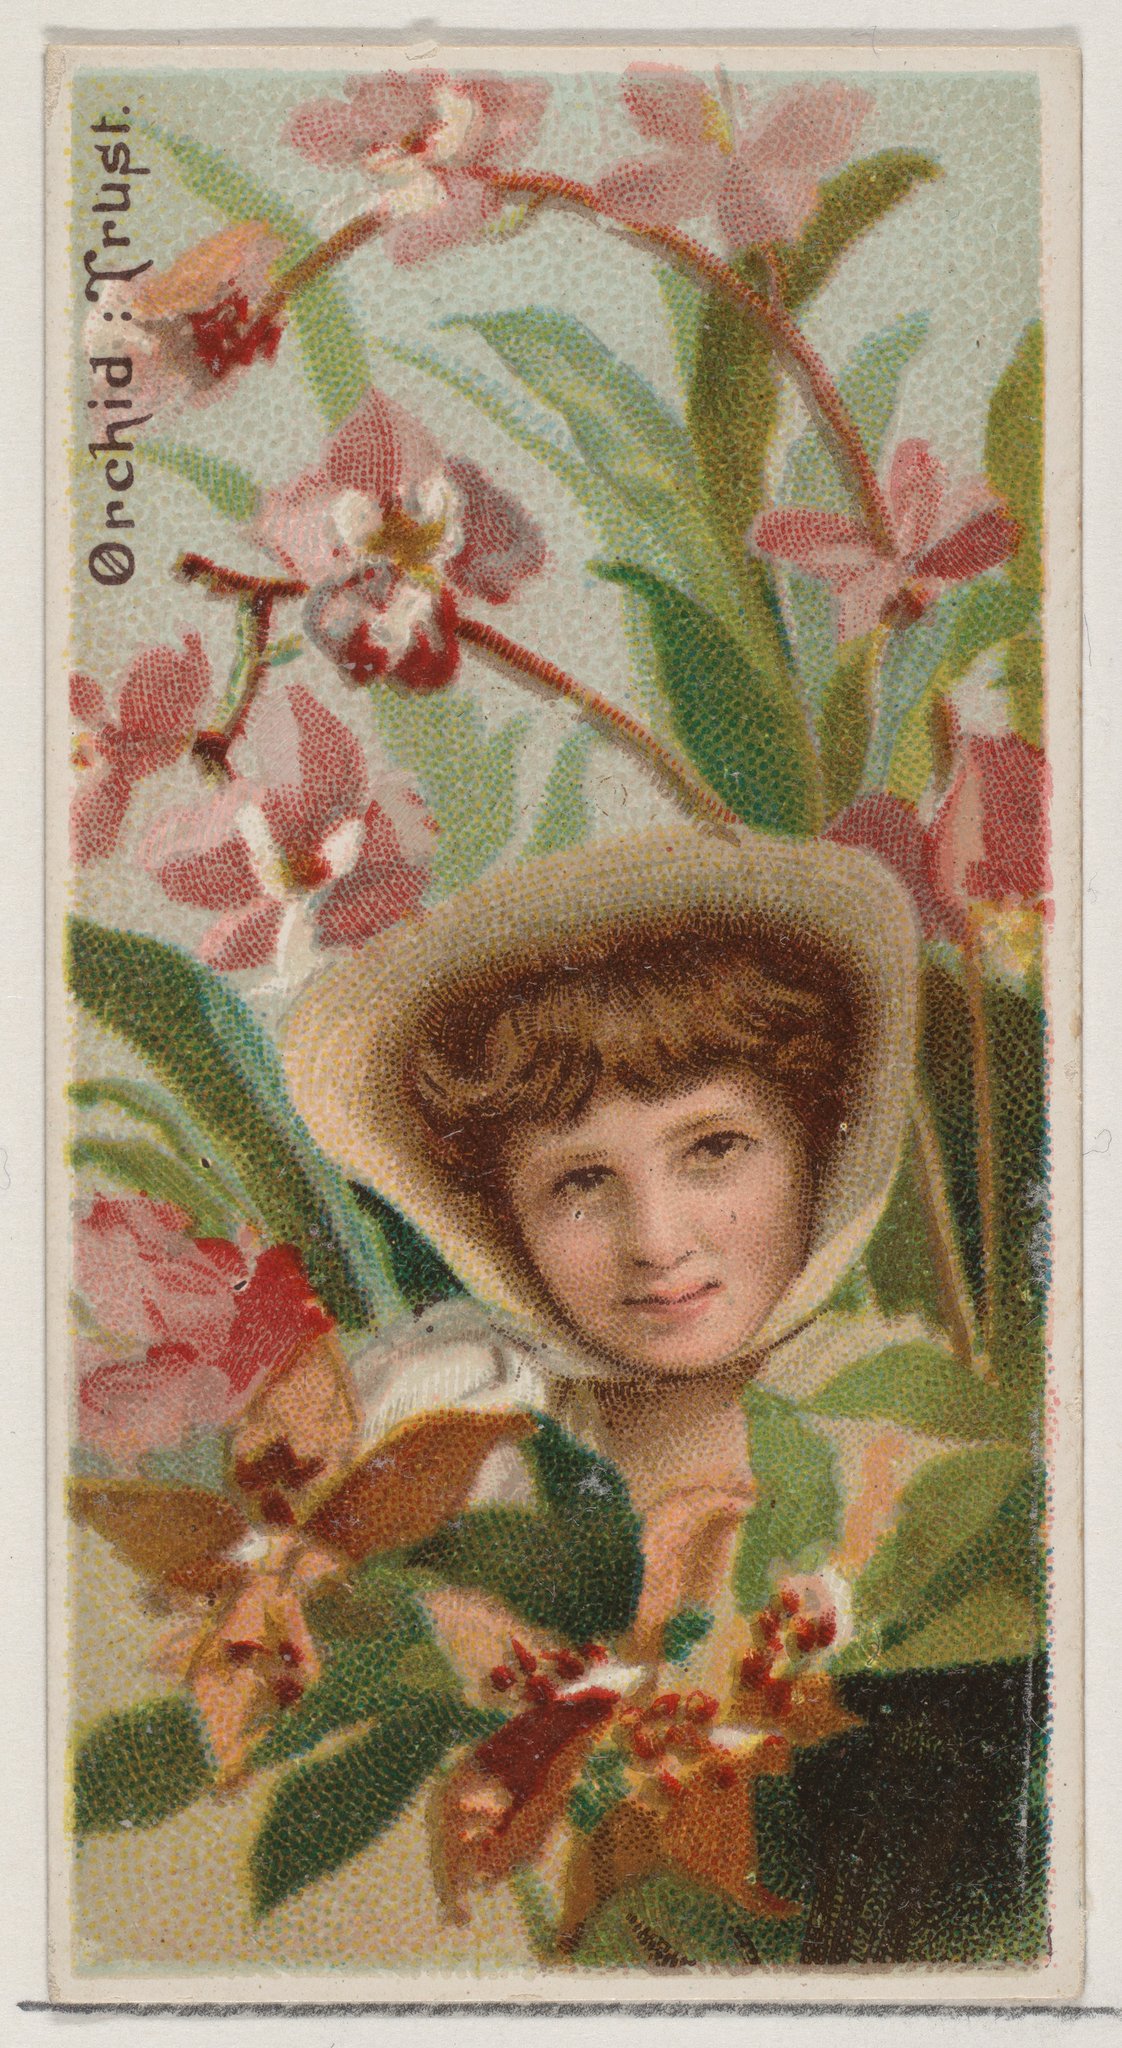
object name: print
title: Orchid: Trust, from the series Floral Beauties and Language of Flowers (N75) for Duke brand cigarettes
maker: american tobacco company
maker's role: publisher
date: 1892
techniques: color lithograph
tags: women,orchids